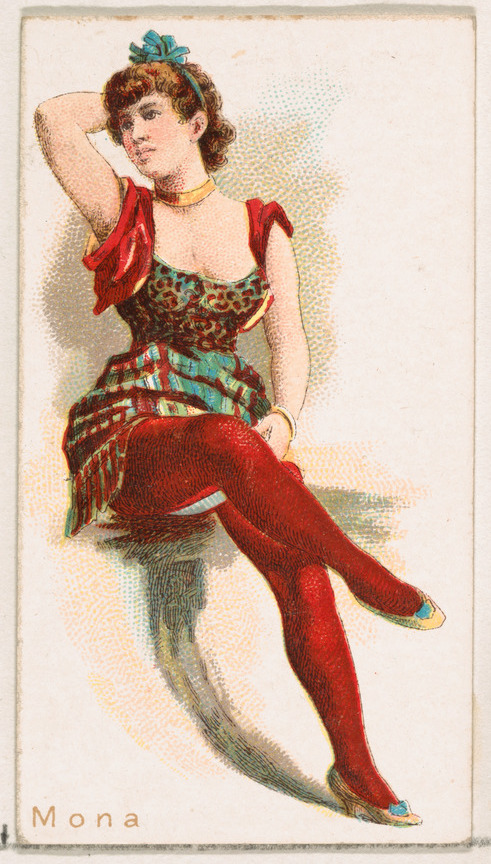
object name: print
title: Mona, from the Ballet Queens series (N182) issued by Wm. S. Kimball & Co.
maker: william s. kimball & company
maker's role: publisher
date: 1889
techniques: color lithograph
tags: women,dancers